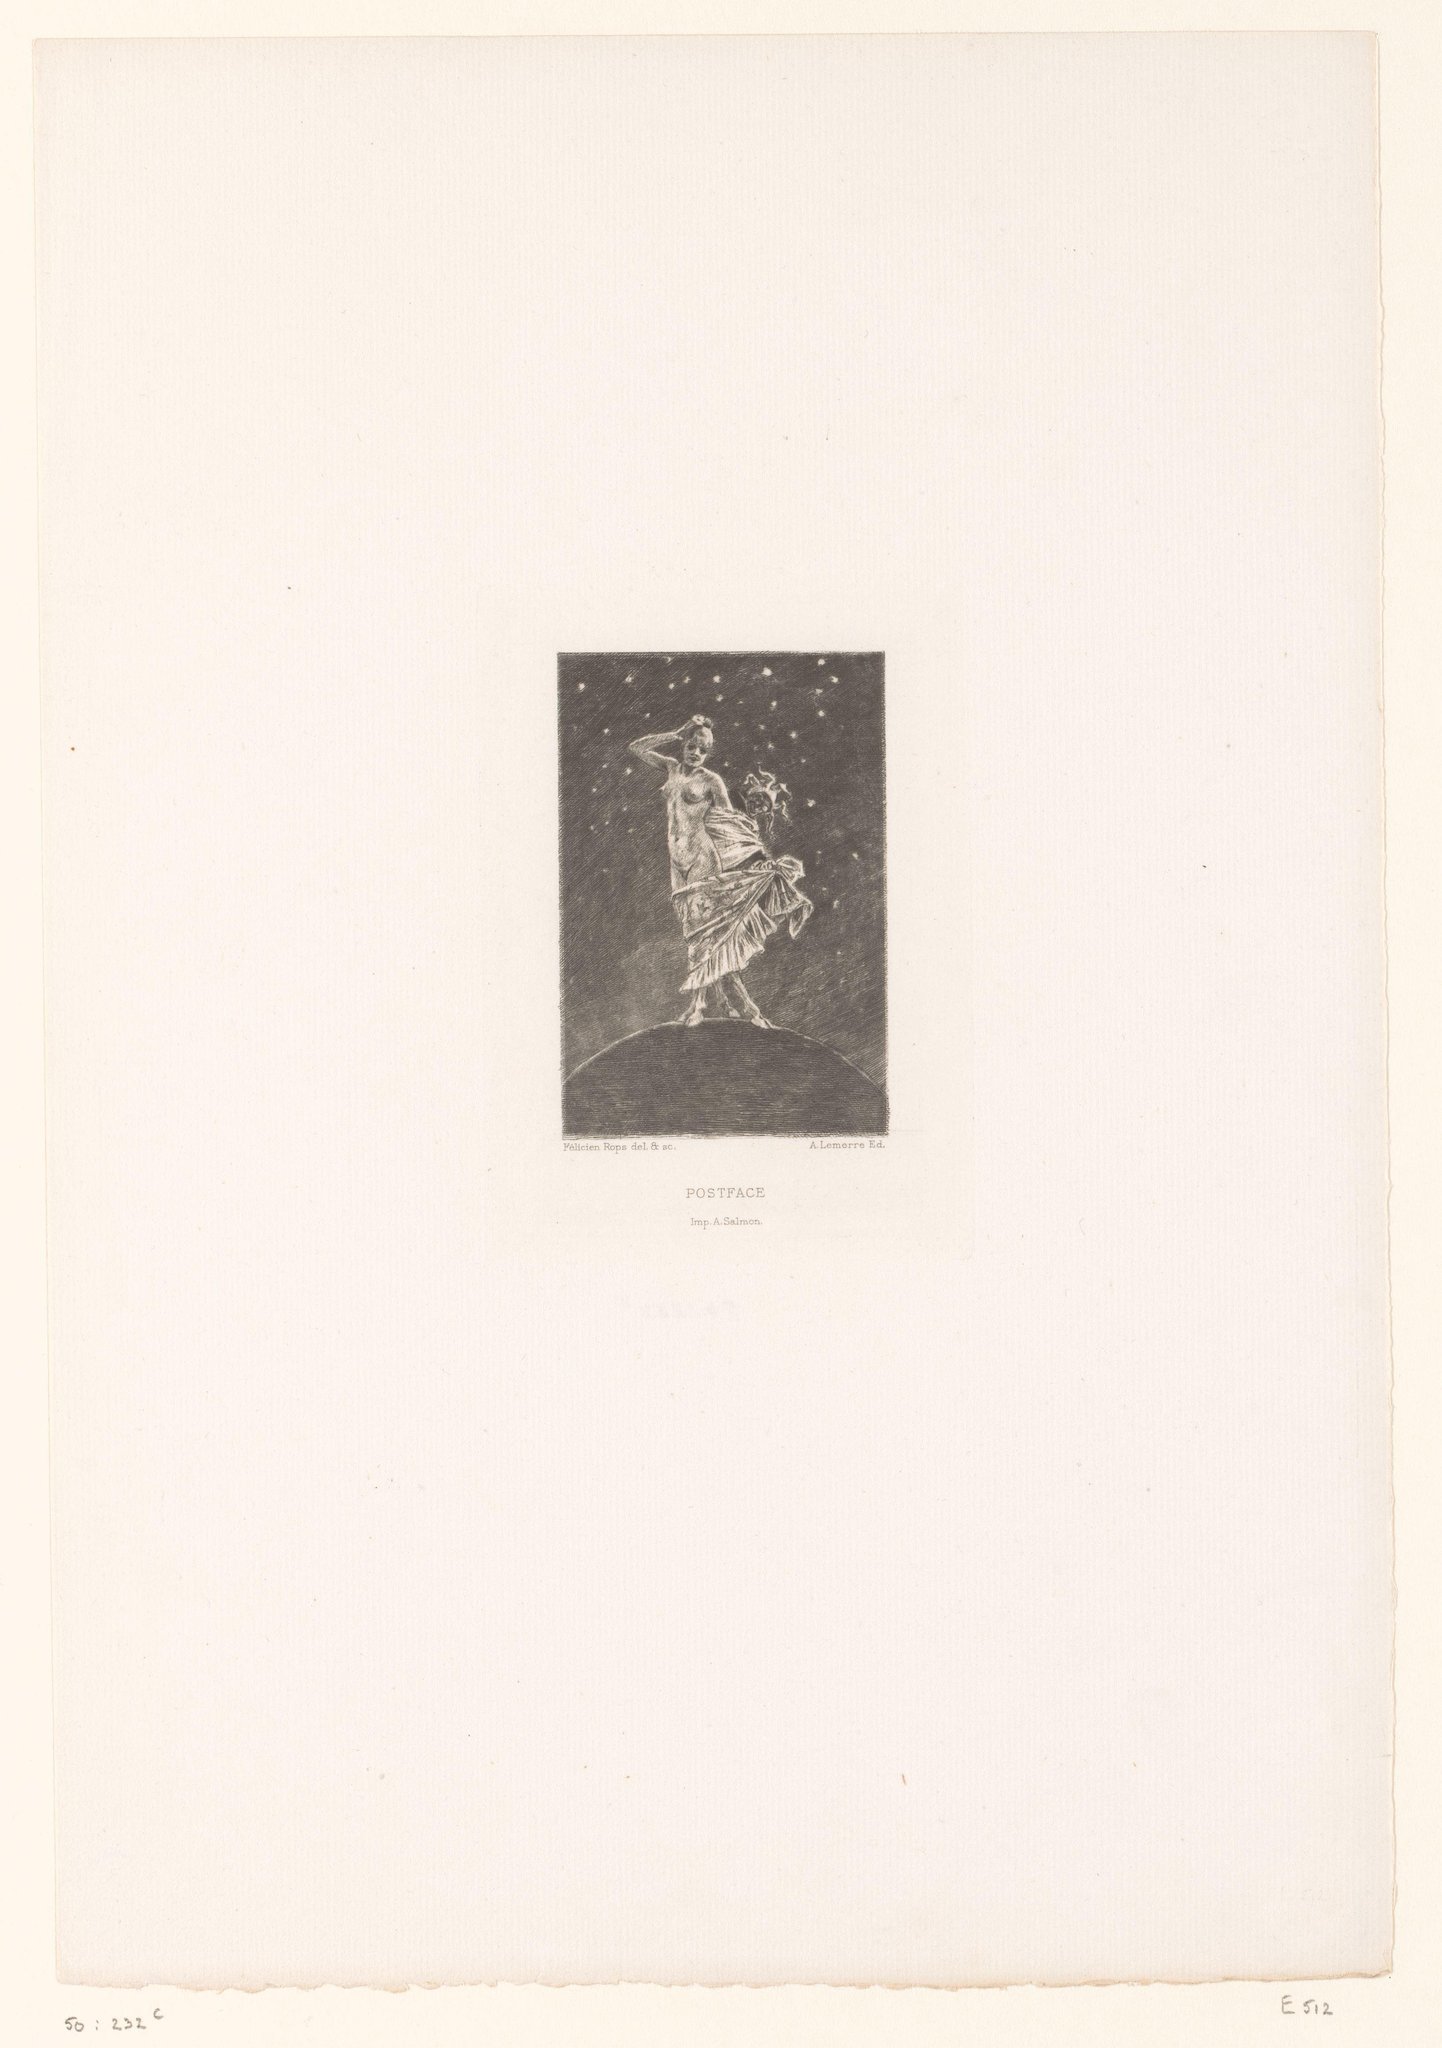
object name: photomechanical print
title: Dix eaux-fortes pour illustrer les diaboliques de J. Barbey-D'Aurevilly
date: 1886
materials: paper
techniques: drypoint, etching, photoaquatint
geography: paris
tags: adult woman, monsters ~ hoofed animals - aa - female human figure, woman (showing herself) undressed, quasi-nude, fool's cap, globe